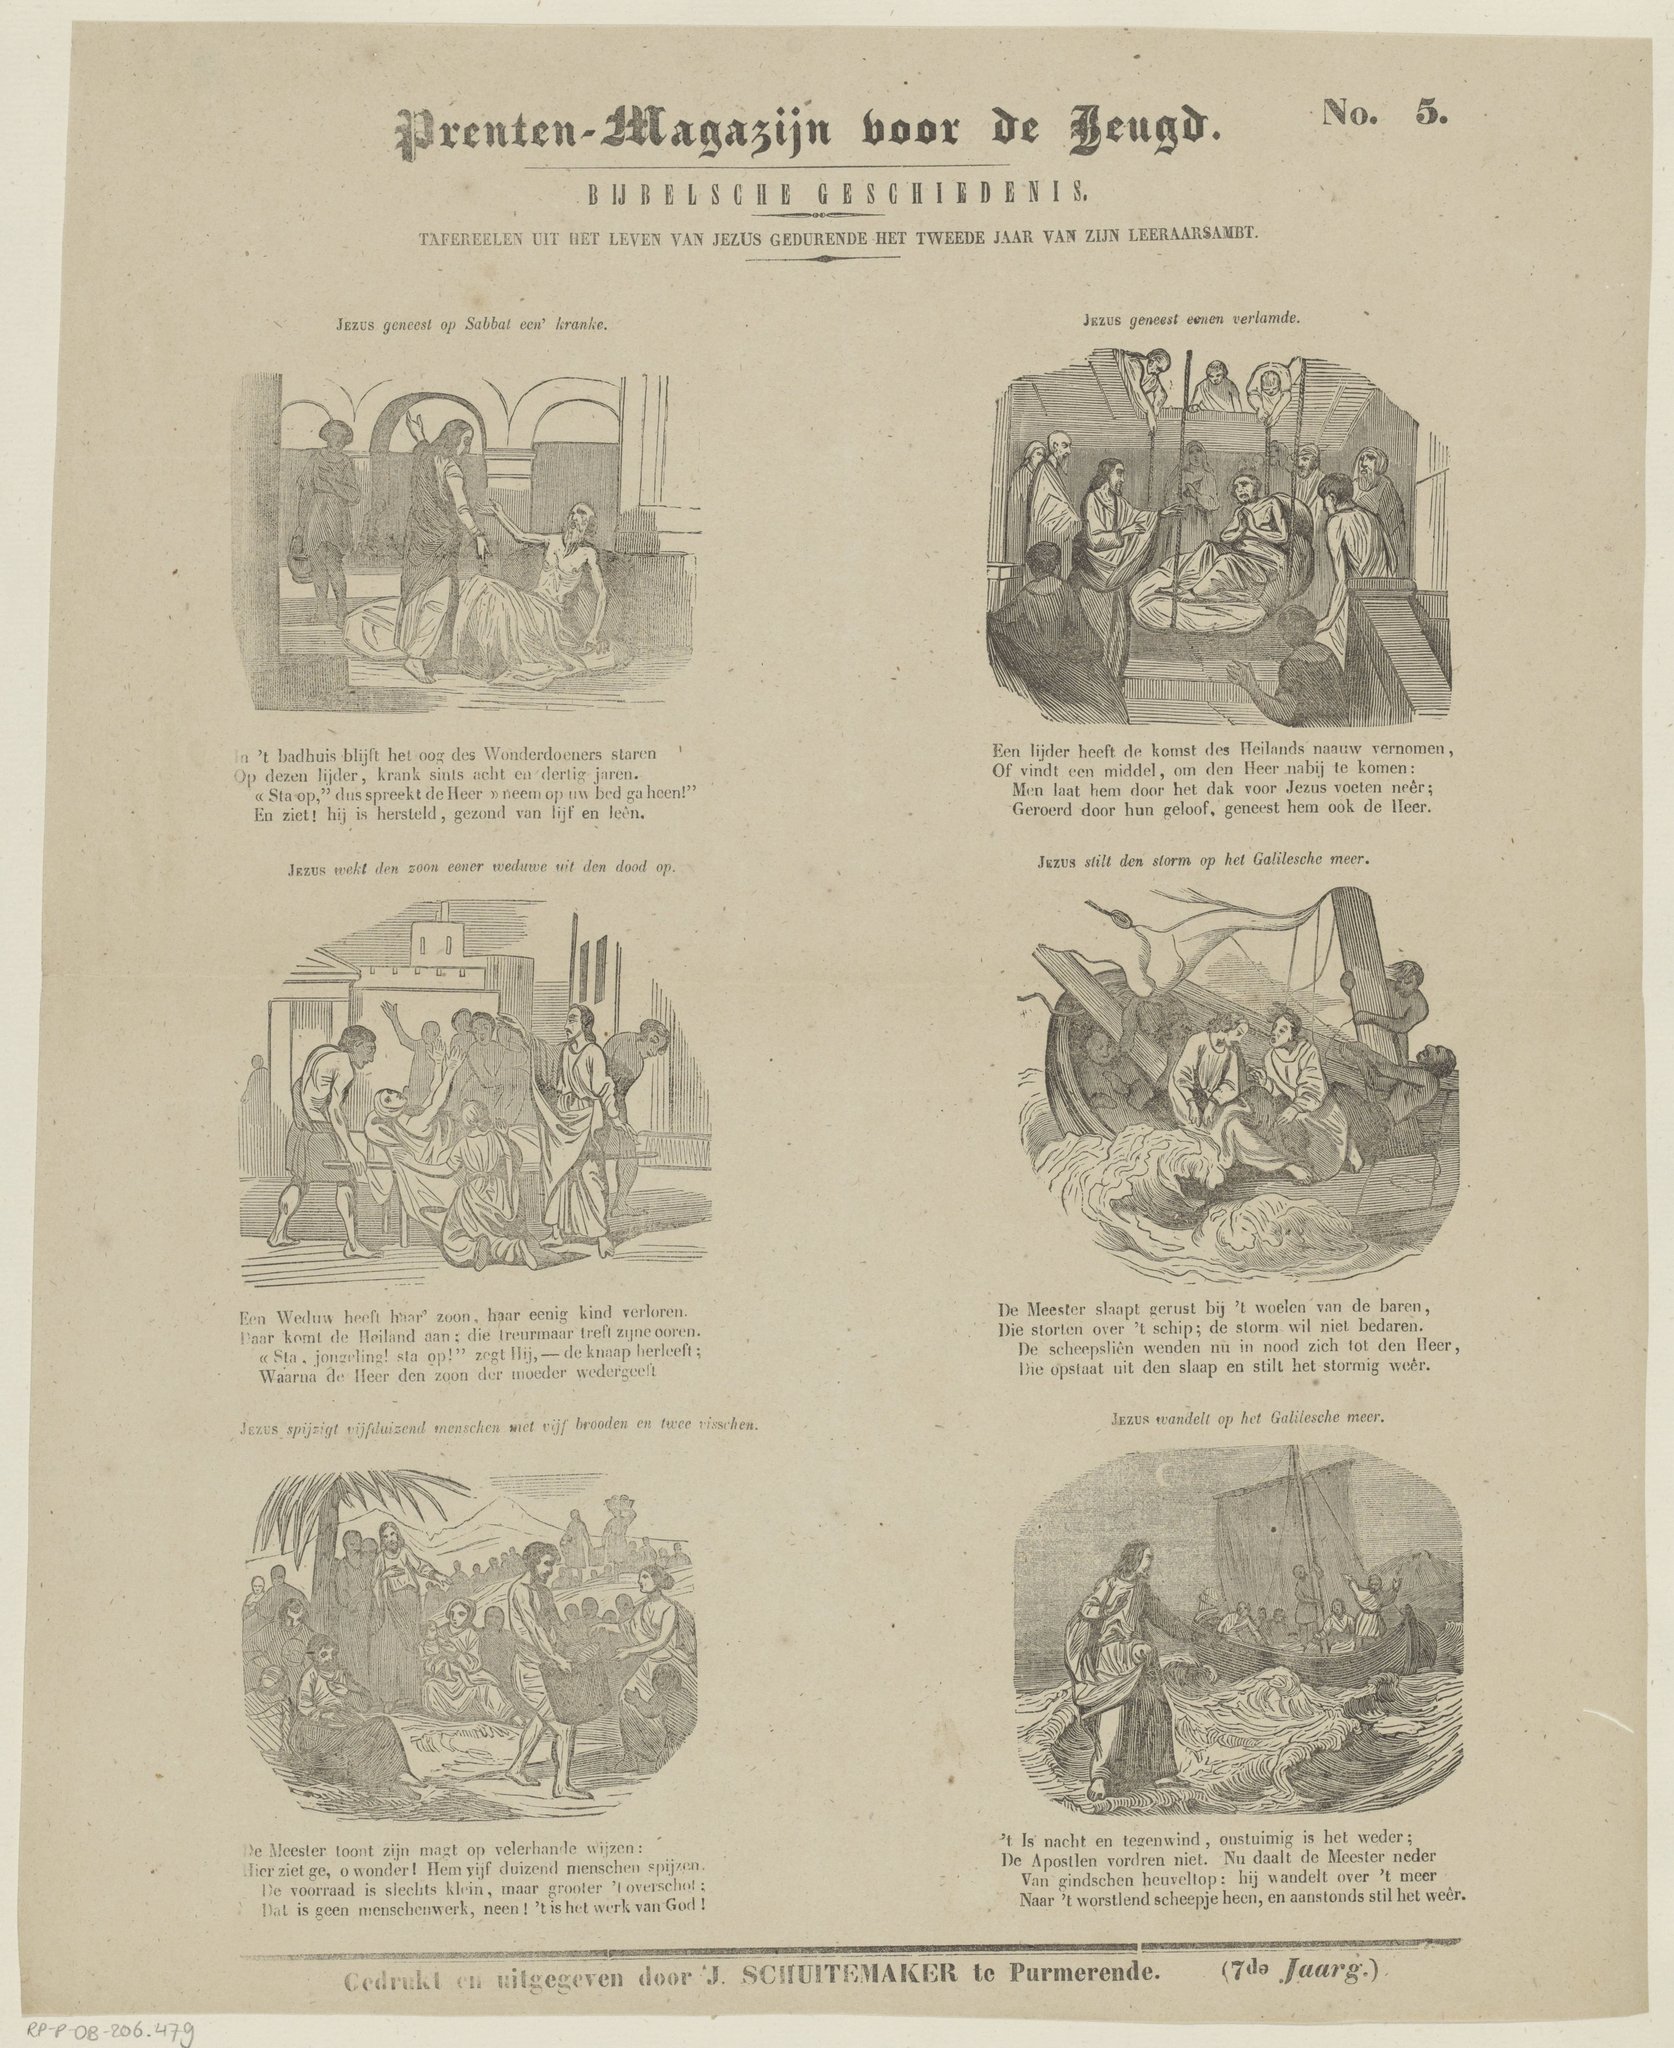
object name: popular print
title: Bijbelsche geschiedenis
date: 1848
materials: paper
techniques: letterpress printing, engraving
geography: purmerend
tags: other healings by christ, multiplication of loaves and fishes for a multitude of four or five thousand people (matthew 14:13-21, 15:32-39; mark 6:32-44, 8:1-10; luke 9:10-17; john 6:1-14), new testament, series of scenes from the life of christ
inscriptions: collector's mark: Lugt 2760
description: Blad met 6 voorstellingen uit het leven van Christus. Boven elke voorstelling een titel en onder elke voorstelling een vierregelig vers. Genummerd rechtsboven: No. 5.